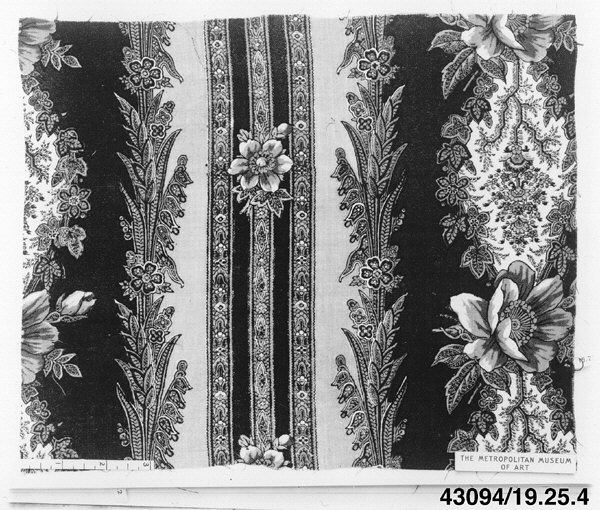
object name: sample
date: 1830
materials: wool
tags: flowers